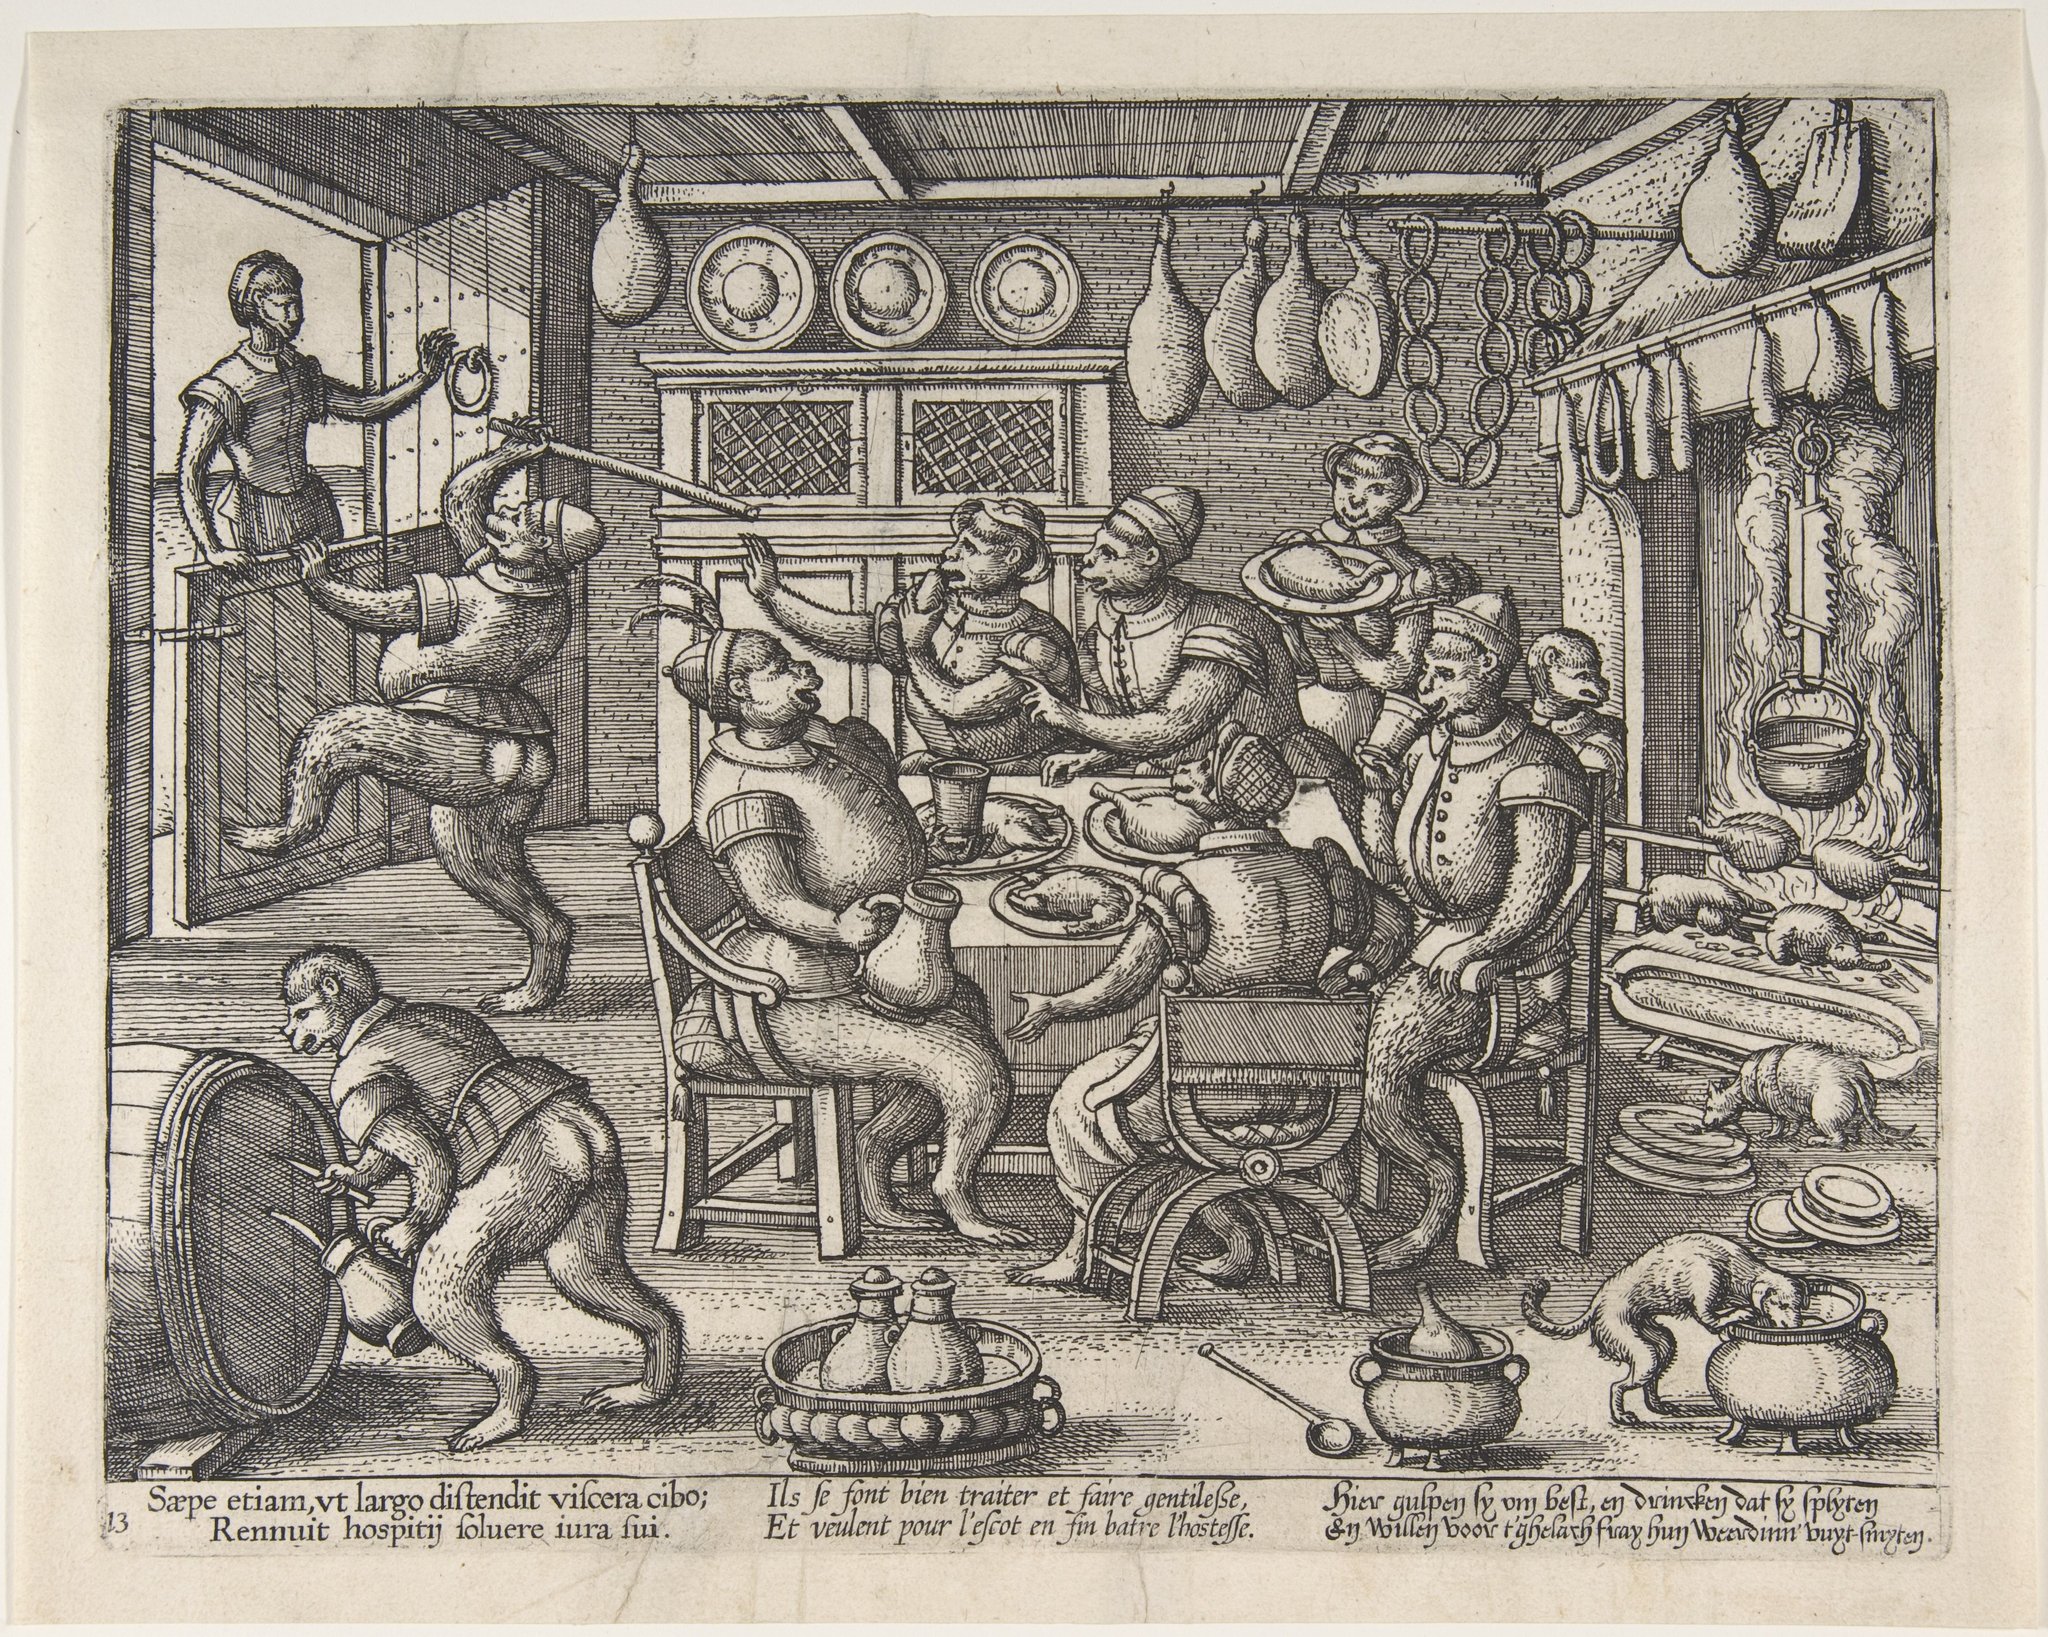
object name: print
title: The Fat Kitchen, from the series Monkeys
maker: peeter van der borcht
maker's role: artist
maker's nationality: netherlandish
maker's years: 1530-1608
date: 1559-1590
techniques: etching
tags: food,kitchens,dogs,monkeys,dining,drinking